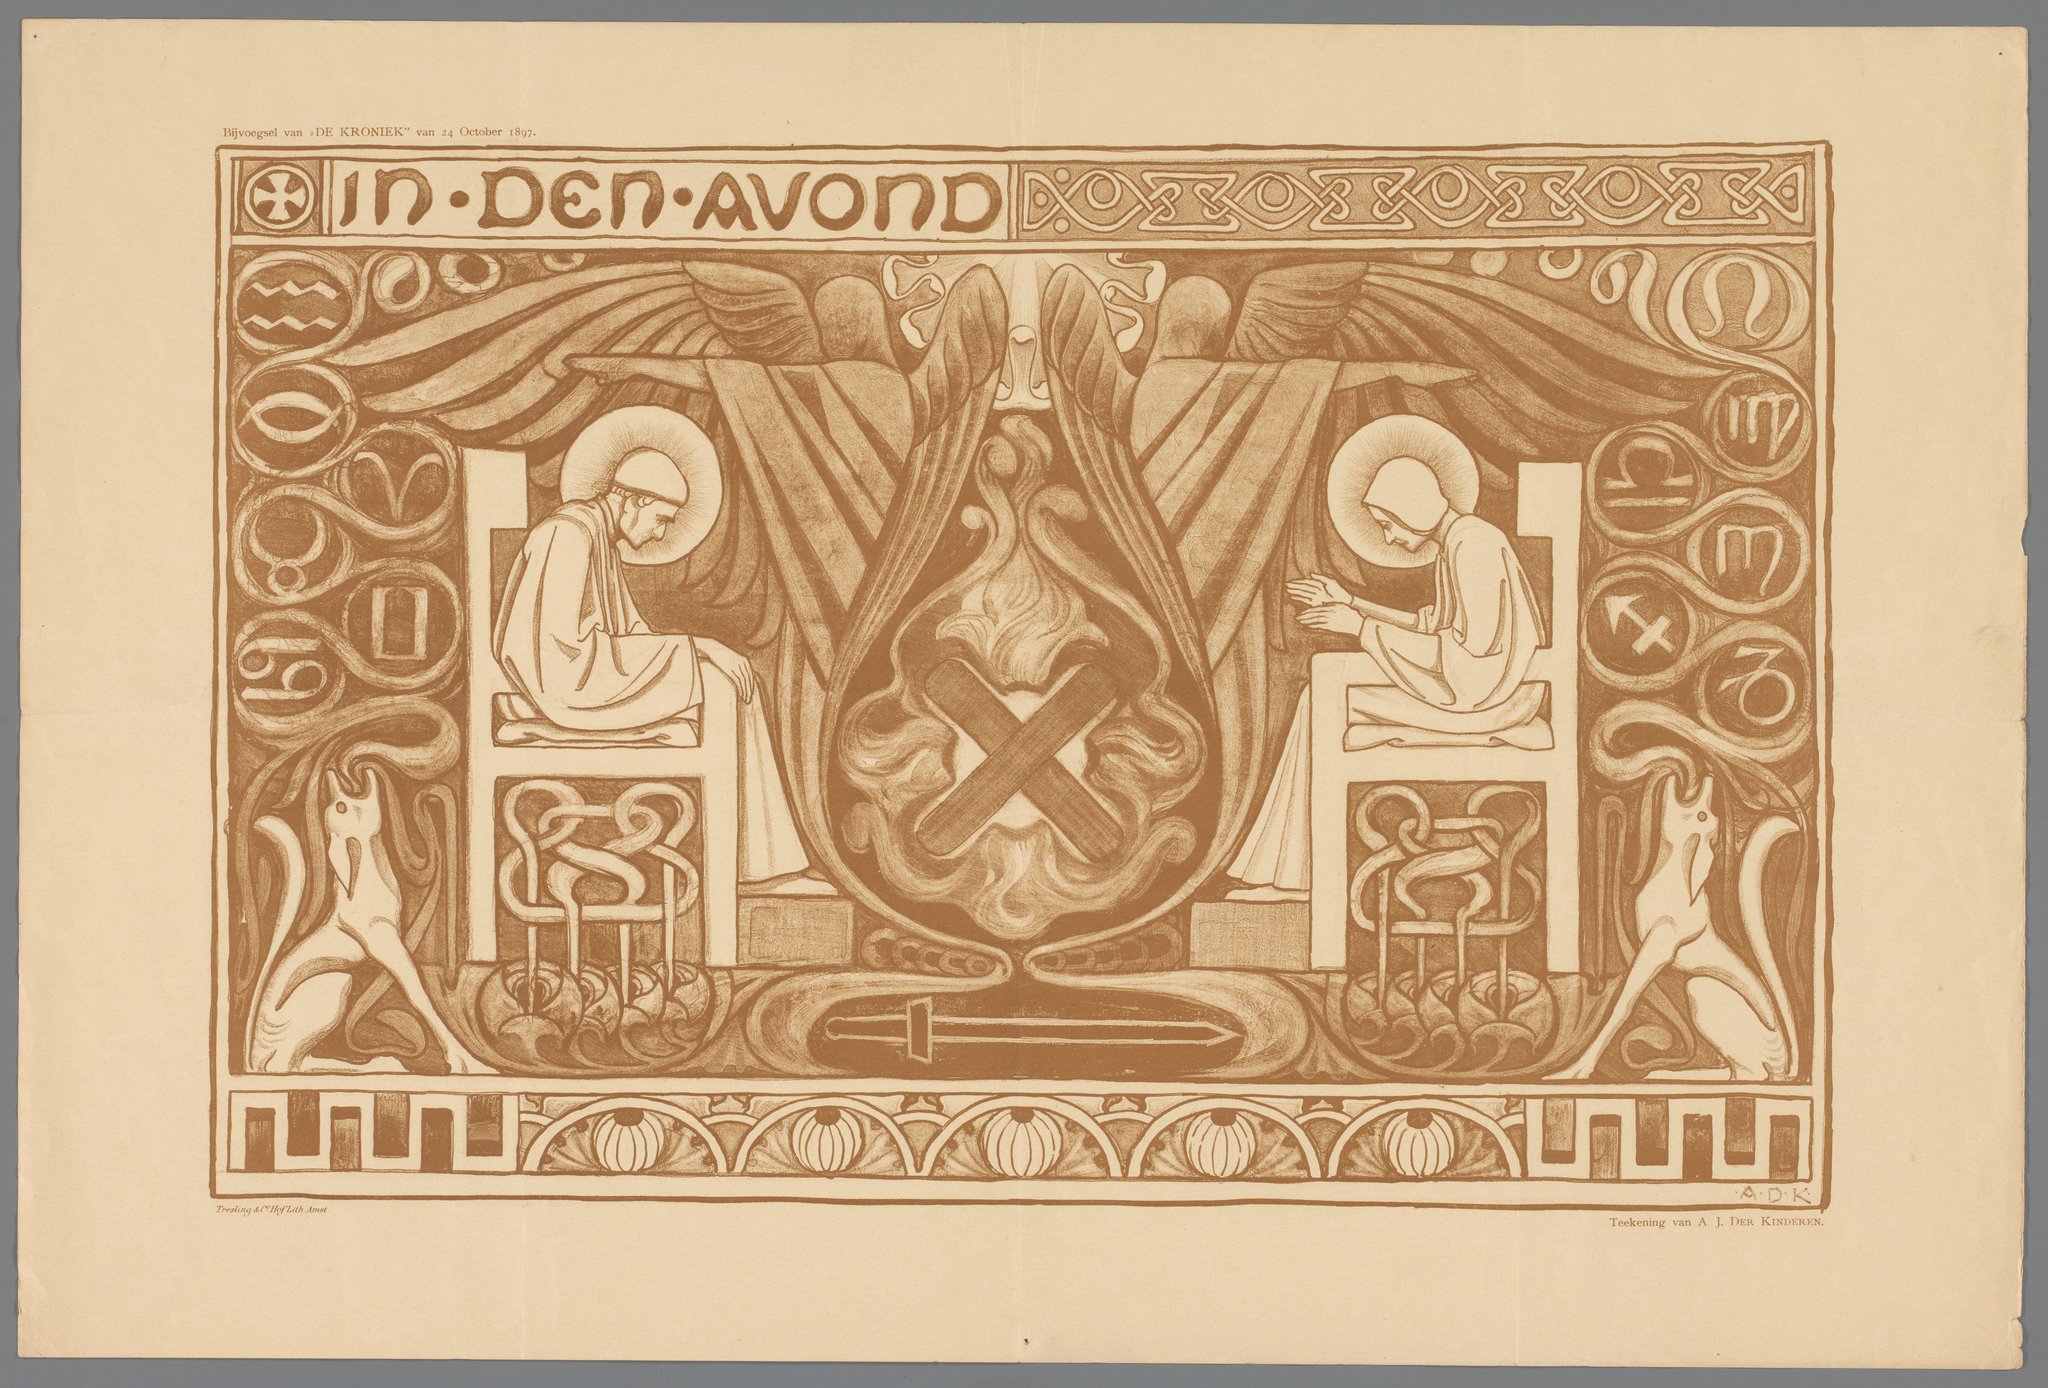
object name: print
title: In den avond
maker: antoon derkinderen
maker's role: draughtsman, painter, print maker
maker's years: 1859-1925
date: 1897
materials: paper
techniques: lithograph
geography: amsterdam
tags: open hearth, fire-place, marriage, married couple, 'matrimonium', zodiac; the twelve zodiacal signs together, fabulous beings with wings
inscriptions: date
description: Een man en vrouw staren in een vuur waarin balken in de vorm van een andreaskruis branden. Onder het vuur een zwaard. Uit het vuur stijgen twee gevleugelde figuren op die hun arm uitstrekken boven het hoofd van de man en vrouw. Uiterst links en uiterst rechts produceren twee honden golvende klanklijnen met daarin tekens uit de dierenriem.